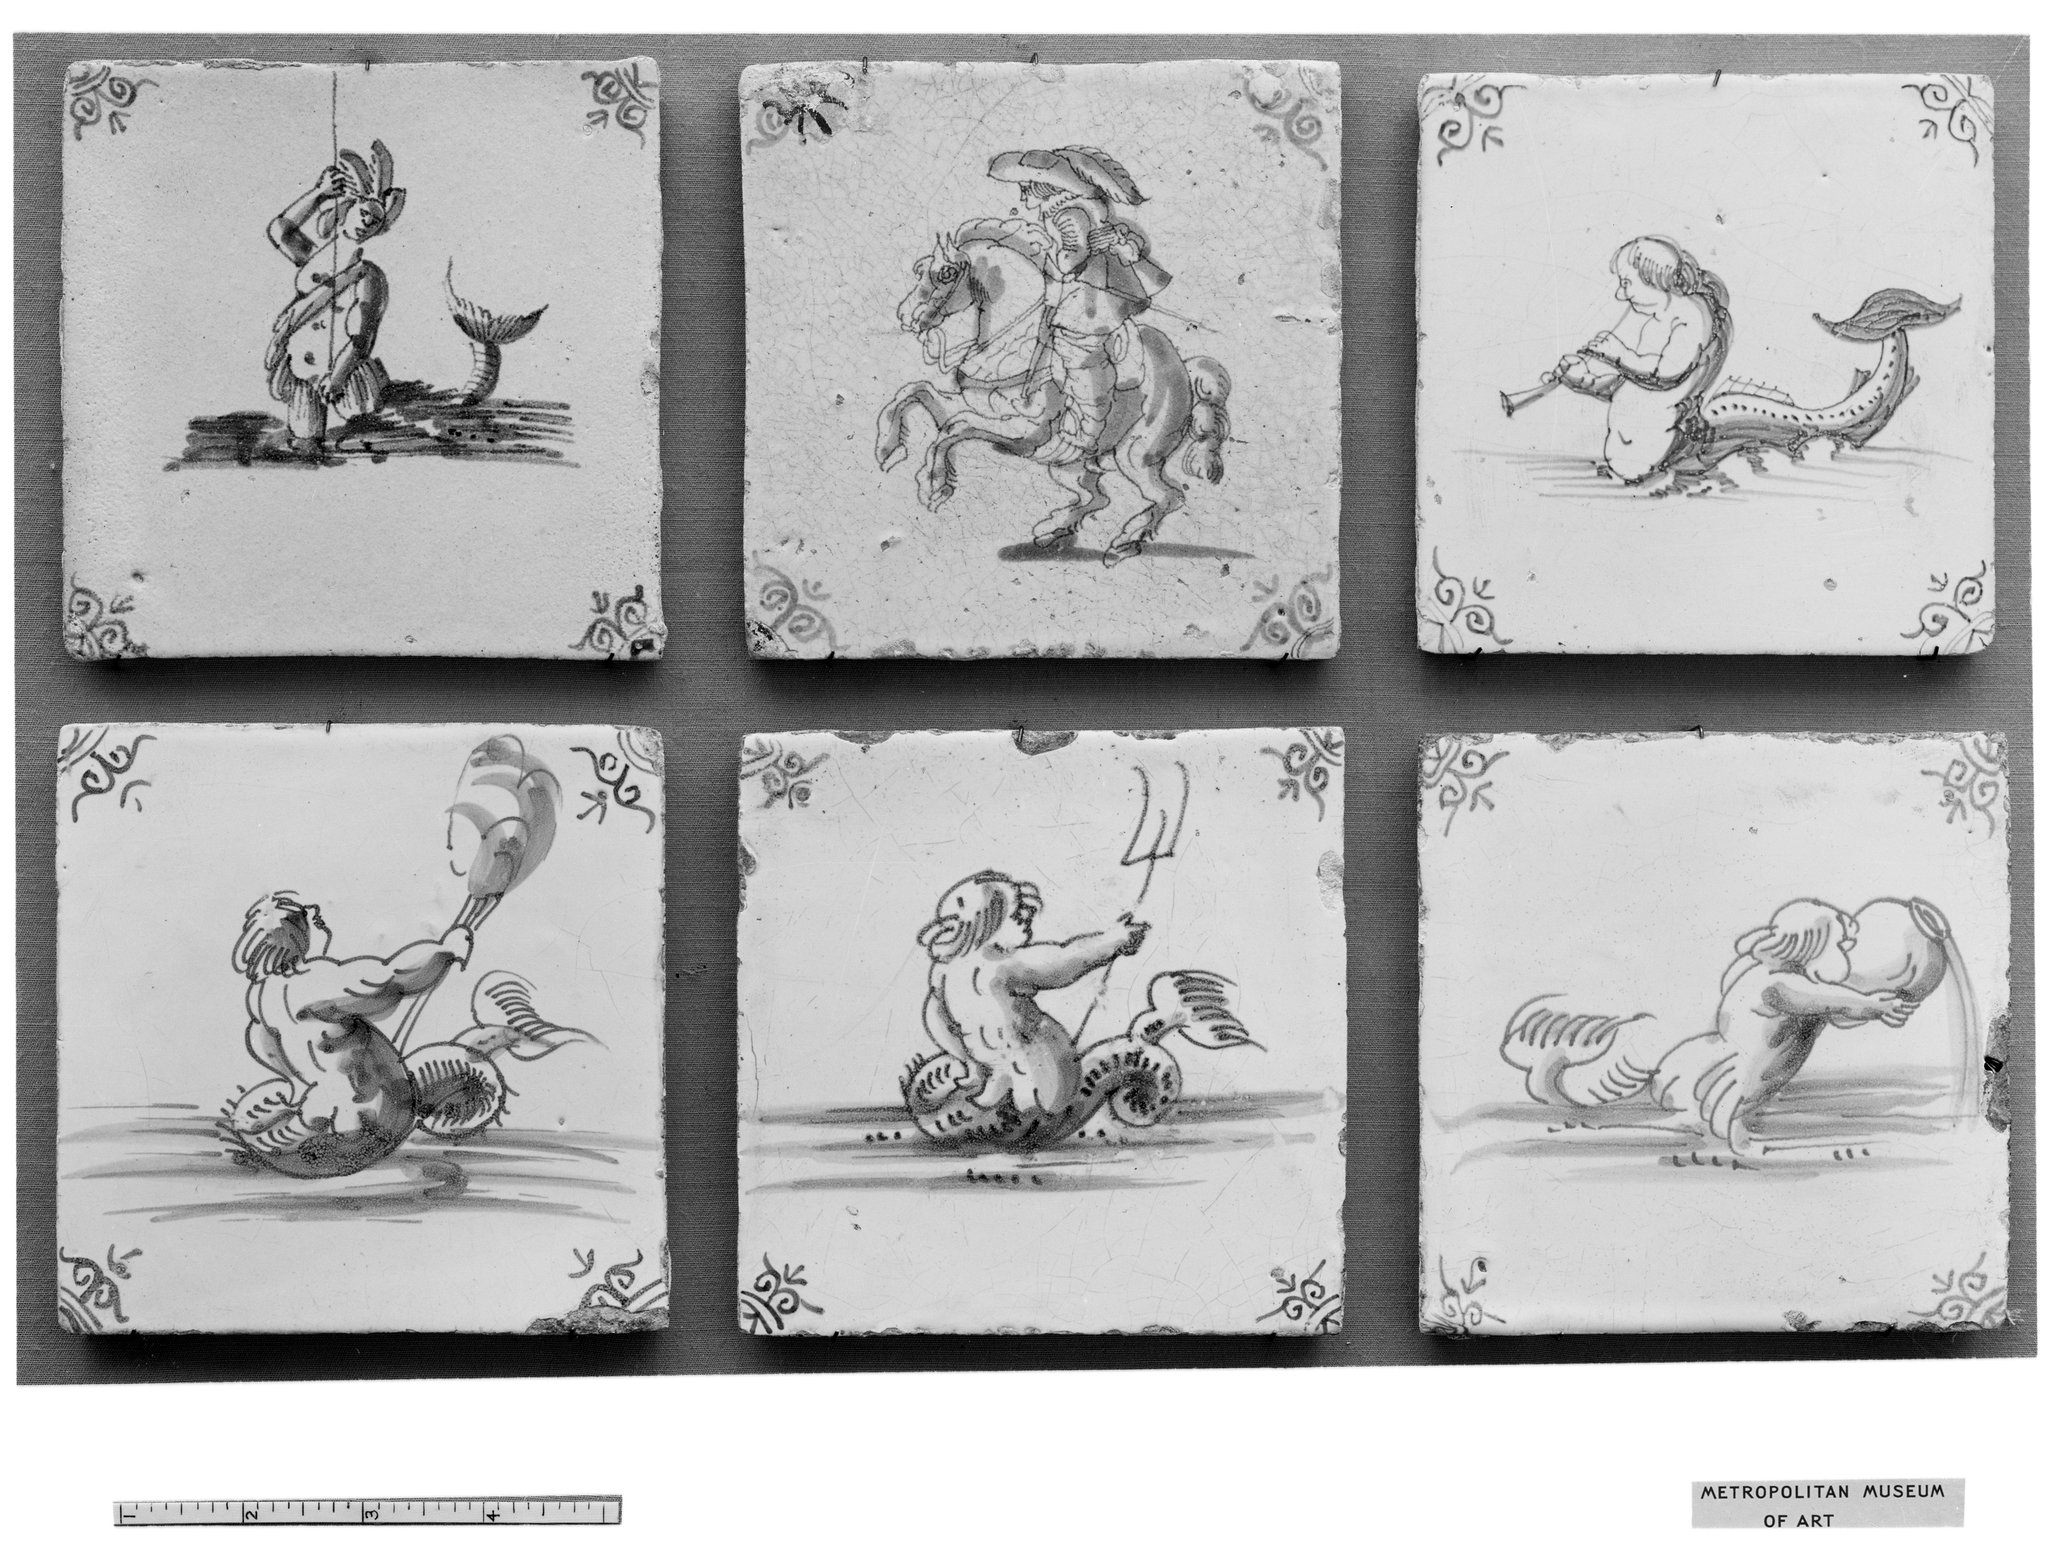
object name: tile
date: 1651-1700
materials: earthenware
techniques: glazing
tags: mermaids,horses